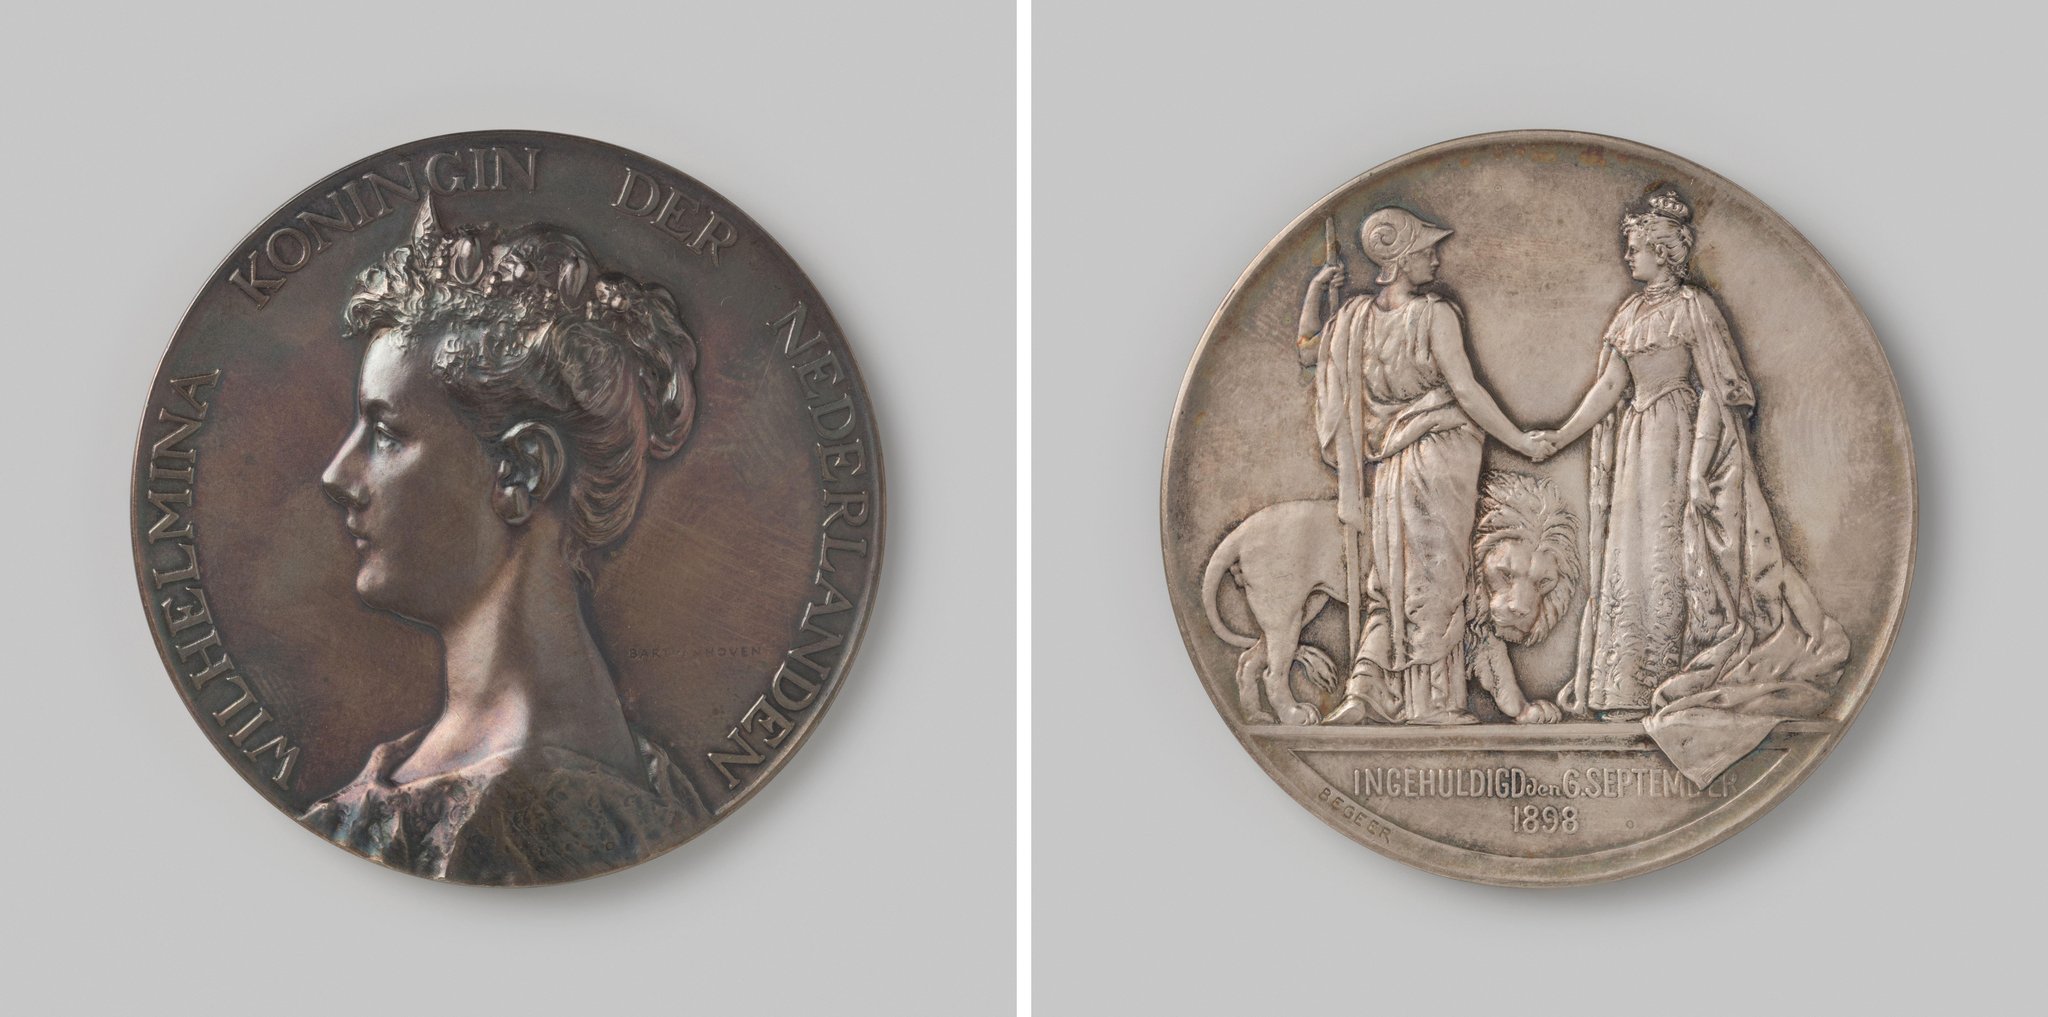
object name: history medal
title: Inhuldiging van Koningin Wilhelmina 1898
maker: bart van hove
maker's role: sculptor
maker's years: 1850-1914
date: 1898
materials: silver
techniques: striking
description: Zilveren penning, op de voorzijde het borstbeeld van Wilhelmina naar links met omschrift, op de keerzijde de Nederlandse Maagd met speer, een leeuw aan haar voeten, drukt de hand van de nieuwe koningin, met afsnedetekst.